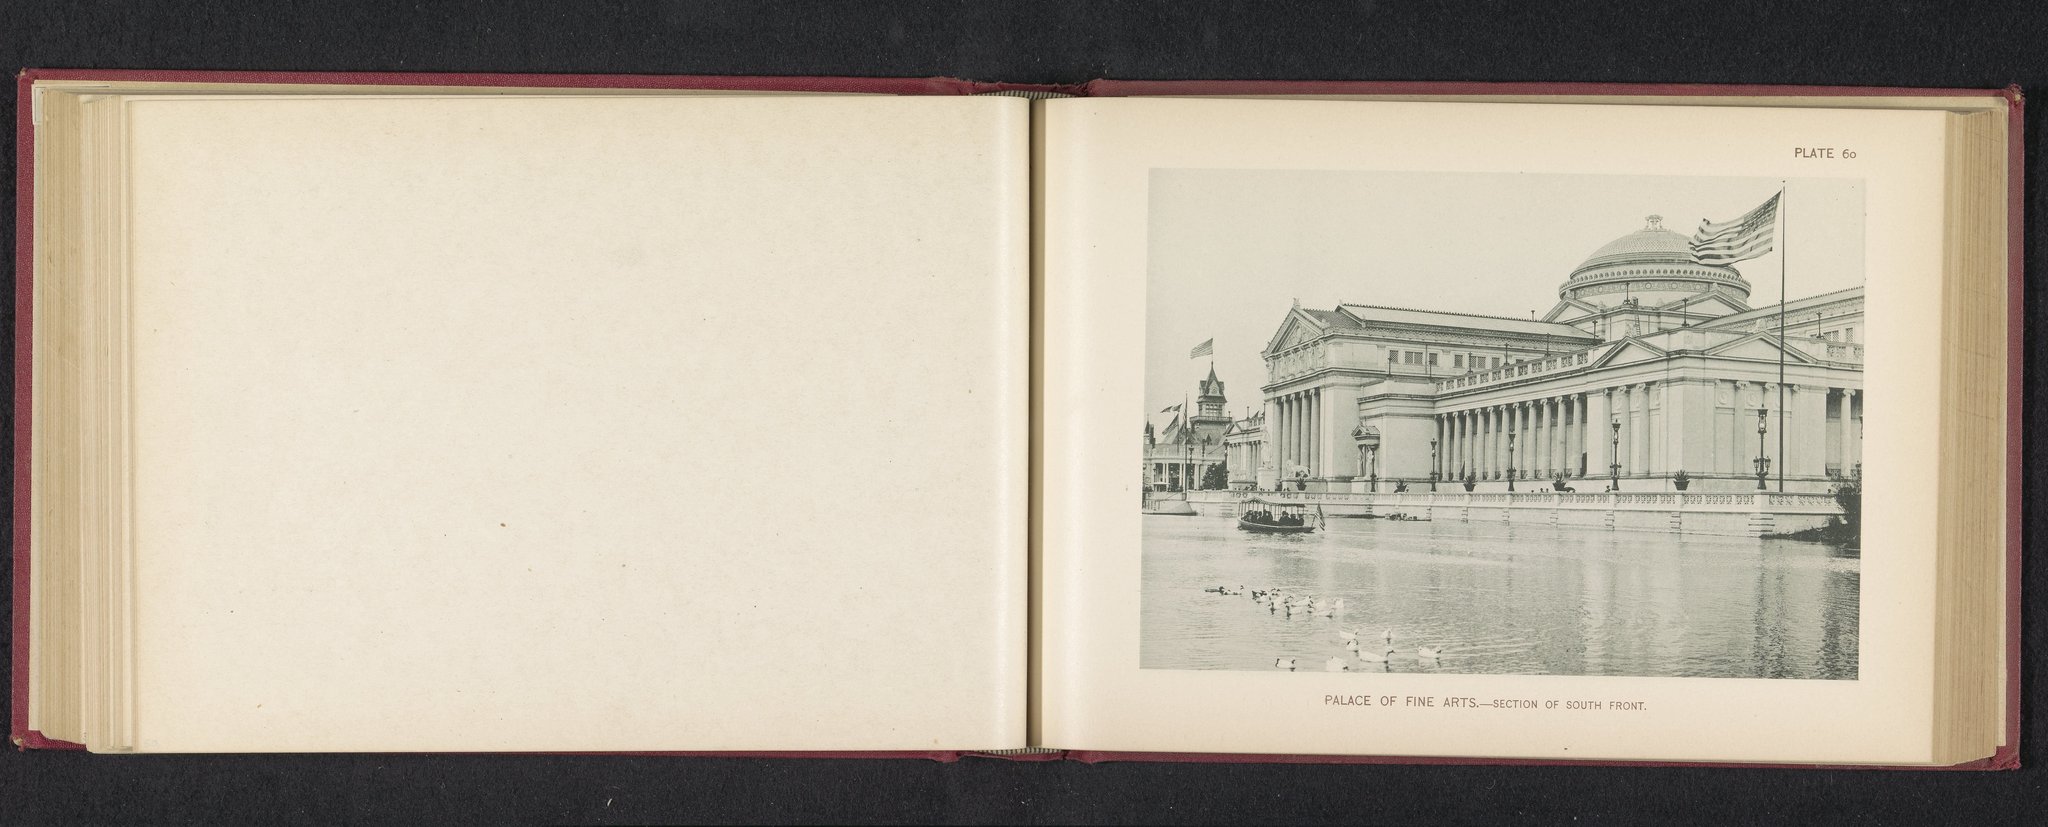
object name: photomechanical print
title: Gezicht op het Palace of Fine Arts op de World's Columbian Exposition in Chicago in 1893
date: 1893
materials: paper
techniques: photograph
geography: chicago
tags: world fair, world exhibition, permanent exhibition, museum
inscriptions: number: ‘Plate 60’